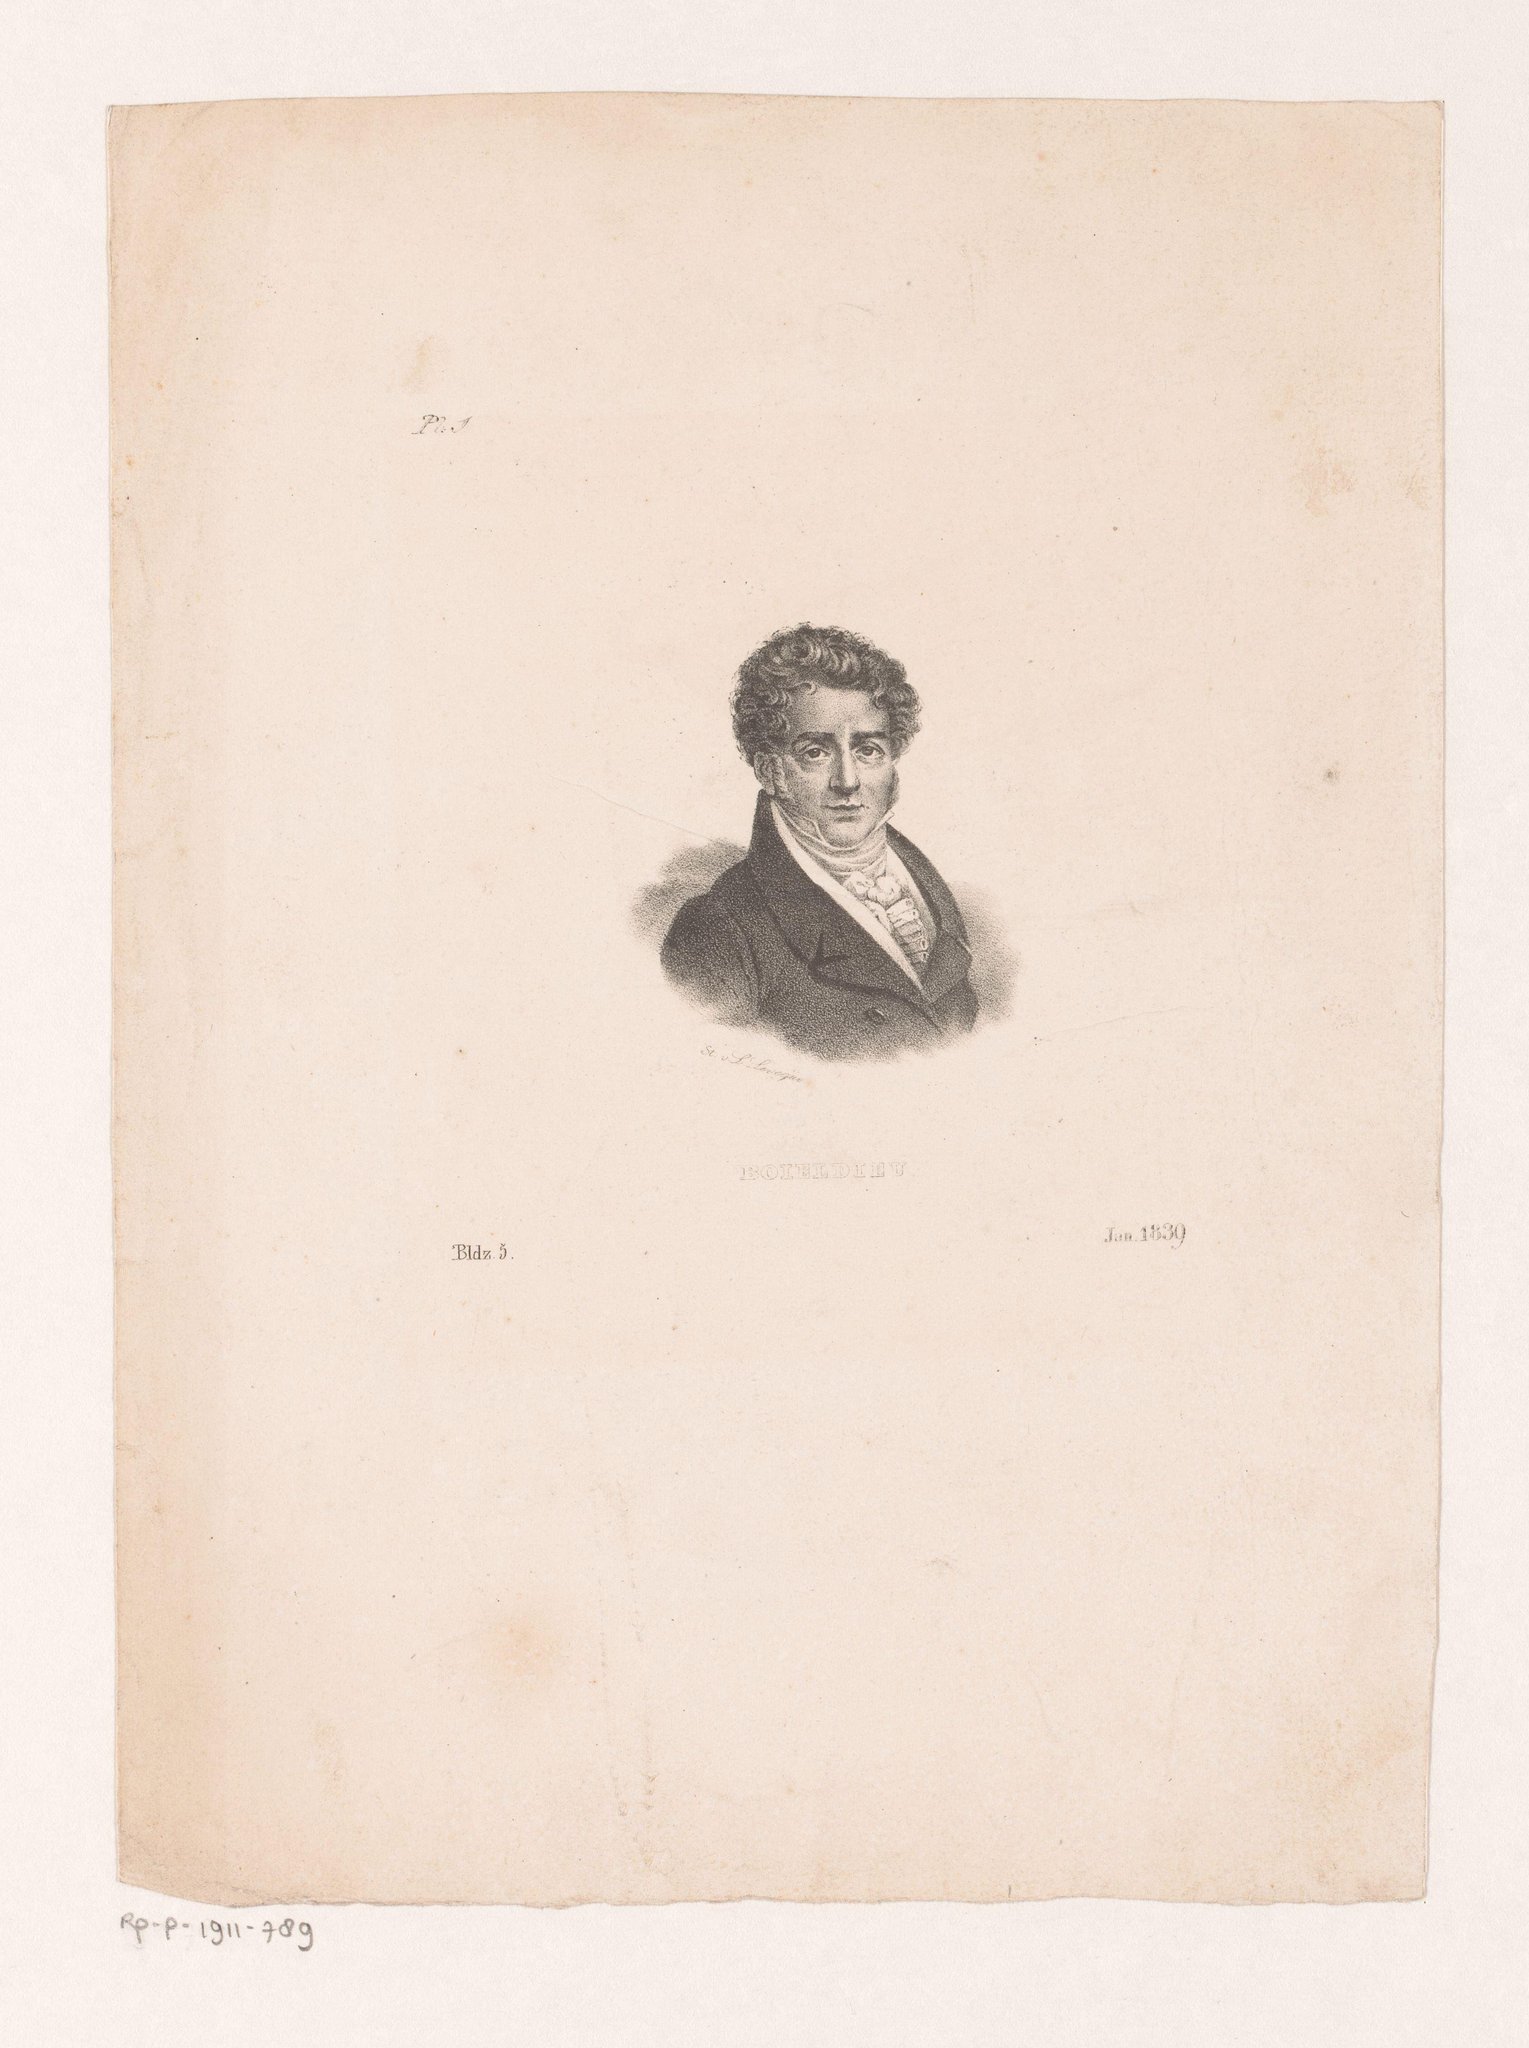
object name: print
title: Portret van François-Adrien Boieldieu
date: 1839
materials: paper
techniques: lithograph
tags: historical persons (+ (full) bust portrait)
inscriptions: collector's mark: Lugt 2228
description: Genummerd linksboven: Pl.1. Linksonder: Bldz.5.